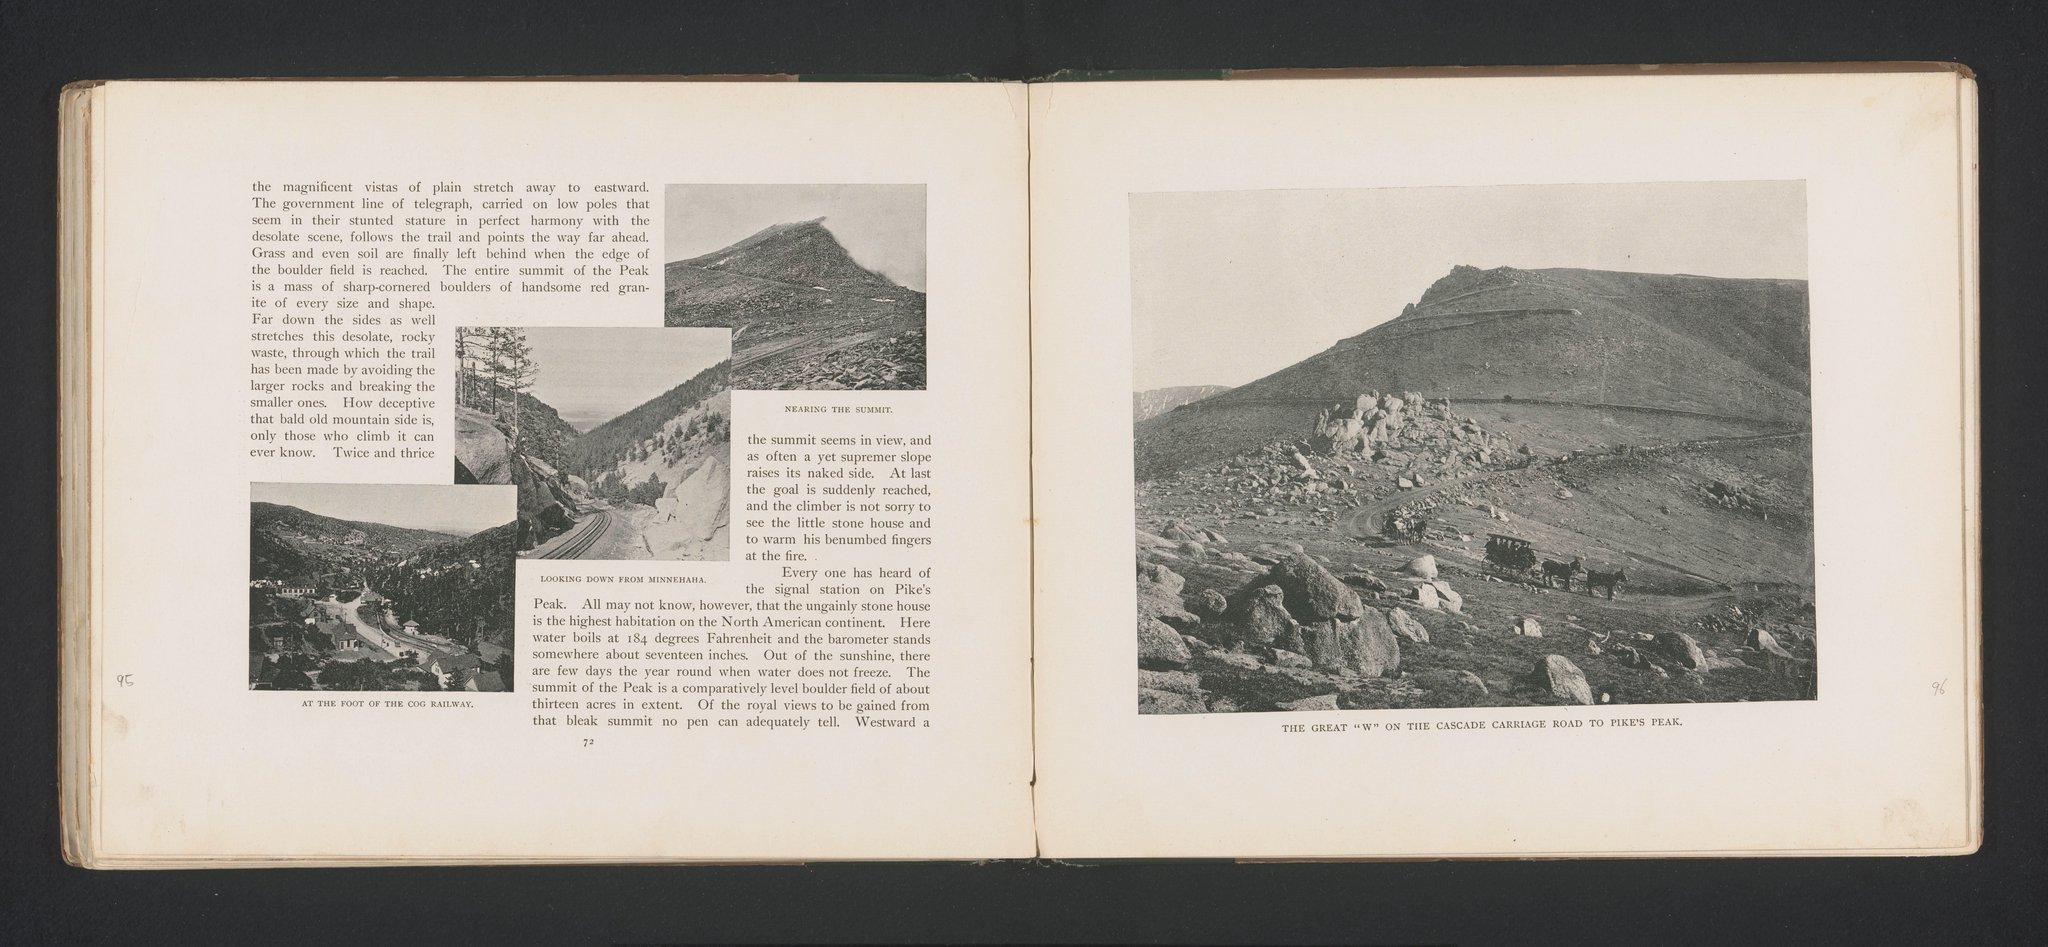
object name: photomontage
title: Fotomontage van landschappen nabij Pikes Peak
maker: Anonymous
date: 1888-1893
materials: paper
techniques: autotype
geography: colorado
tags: landscapes, city-view in general; 'veduta', mountain-top, peak, railway, train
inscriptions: inscription: ‘At the foot of the Cog railway/ Looking down from Minnehaha/ nearing the summit’